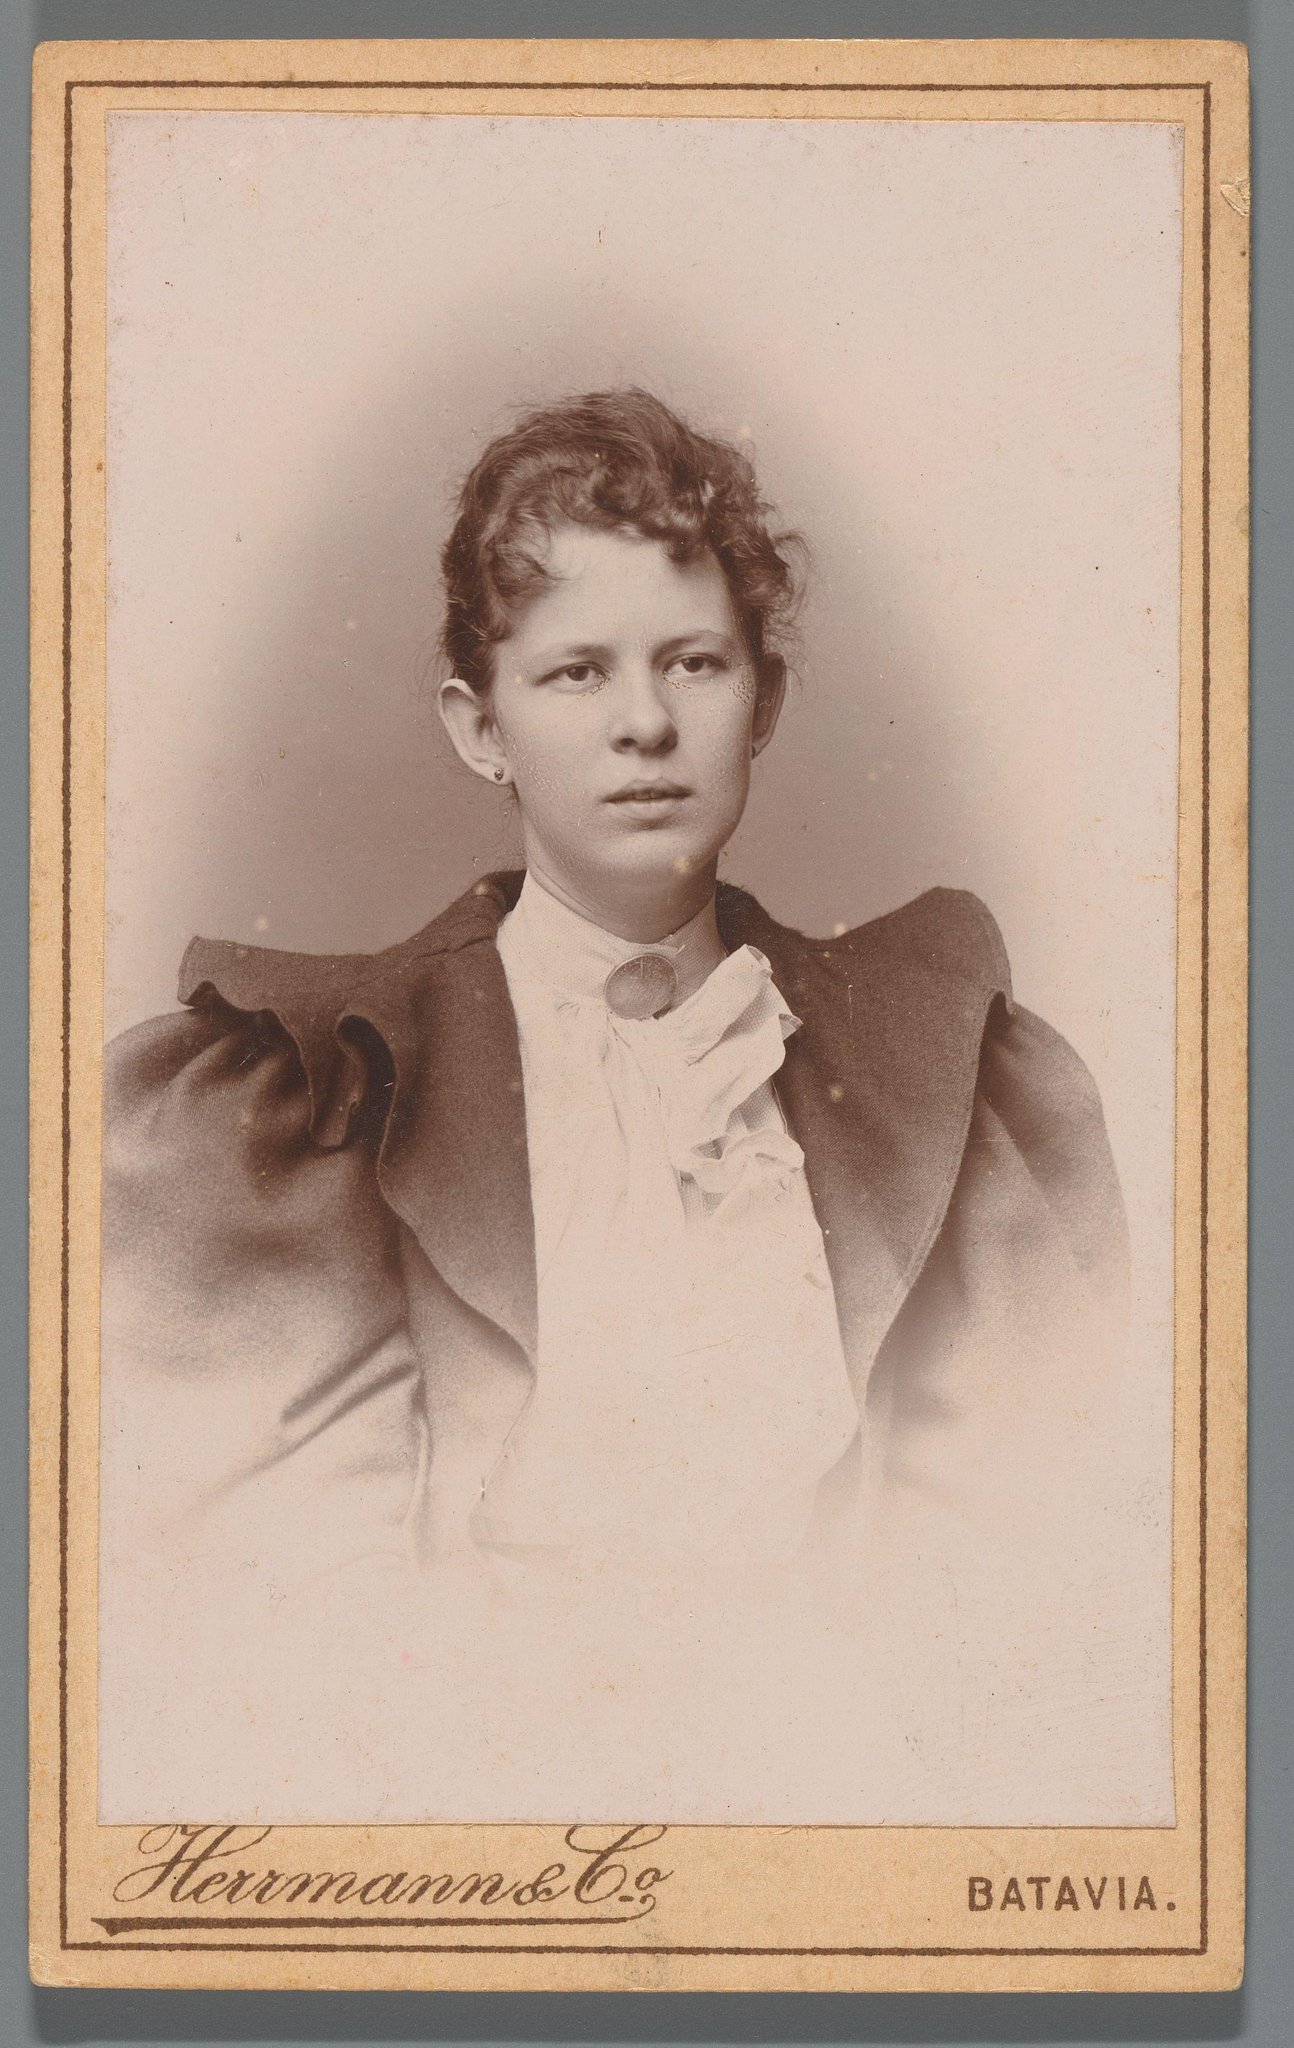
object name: carte de visite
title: Portret van tante Dé van den Berg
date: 1894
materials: cardboard, photographic support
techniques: albumen print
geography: batavia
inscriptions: name: ‘Herrmann & Co BATAVIA.’, name: ‘Photograph. Atelier / Herrmann & Co / BATAVIA (OST-INDIEN)’, inscription: ‘... W. B. v. d. Berg / tante Dé / 1894’